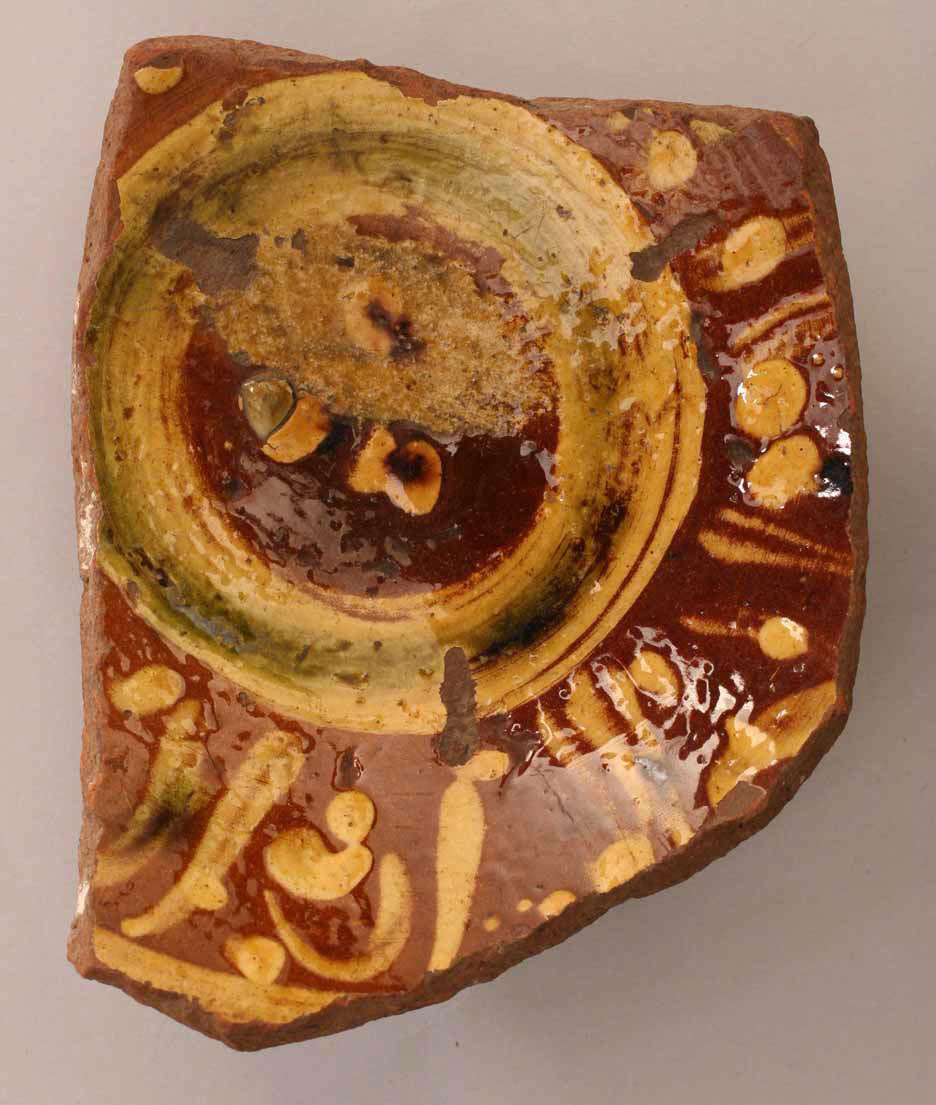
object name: ceramic fragment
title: Fragment of a Bowl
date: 1301-1500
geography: egypt